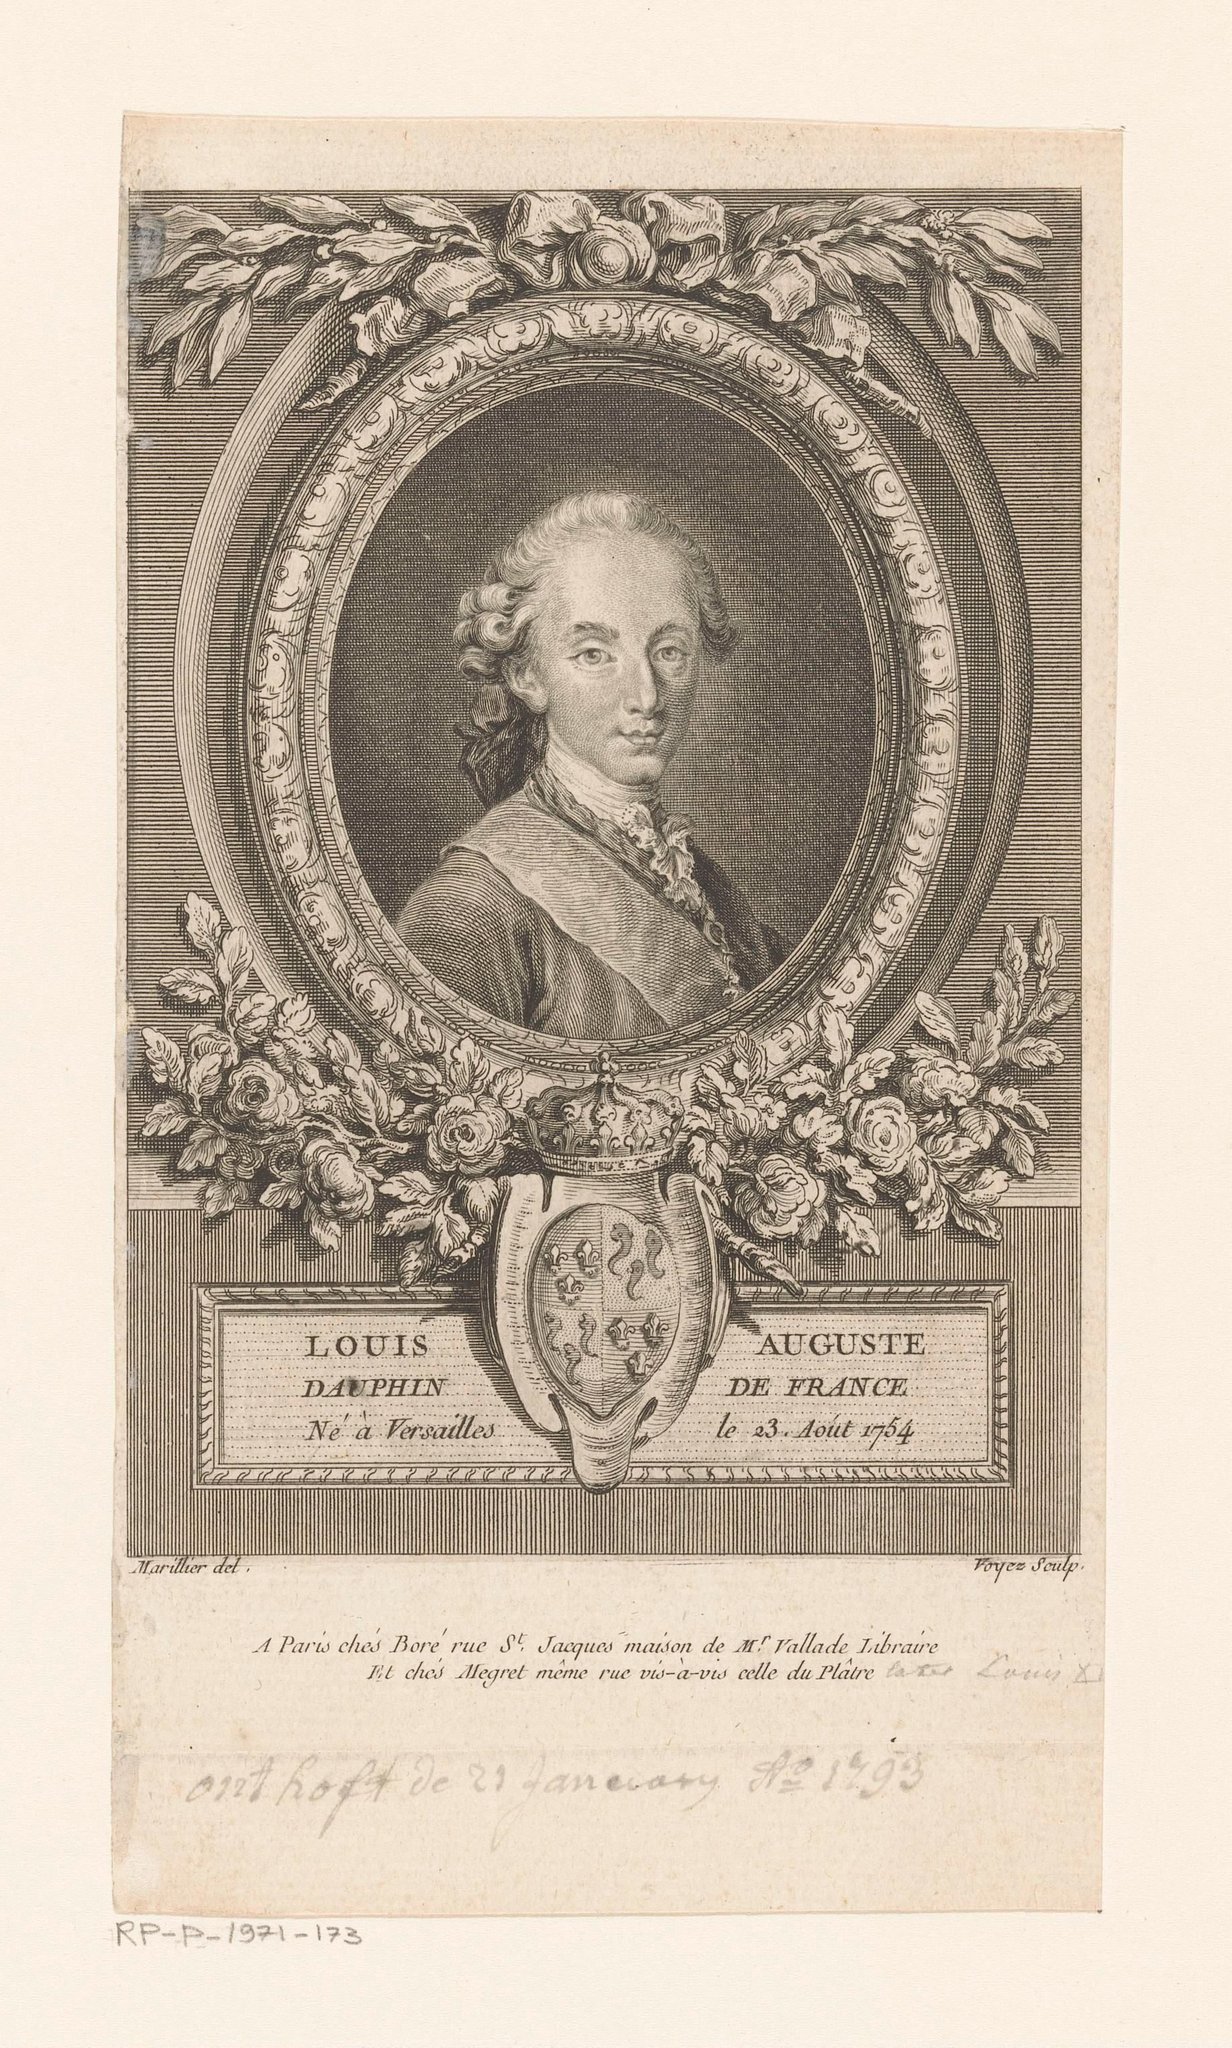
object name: print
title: Portret van Lodewijk XVI van Frankrijk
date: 1756-1805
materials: paper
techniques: engraving, etching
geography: paris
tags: paris, lodewijk xvi (koning van frankrijk), historical persons, flowers: rose, king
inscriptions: collector's mark: Lugt 2760, collector's mark: Lugt 2228